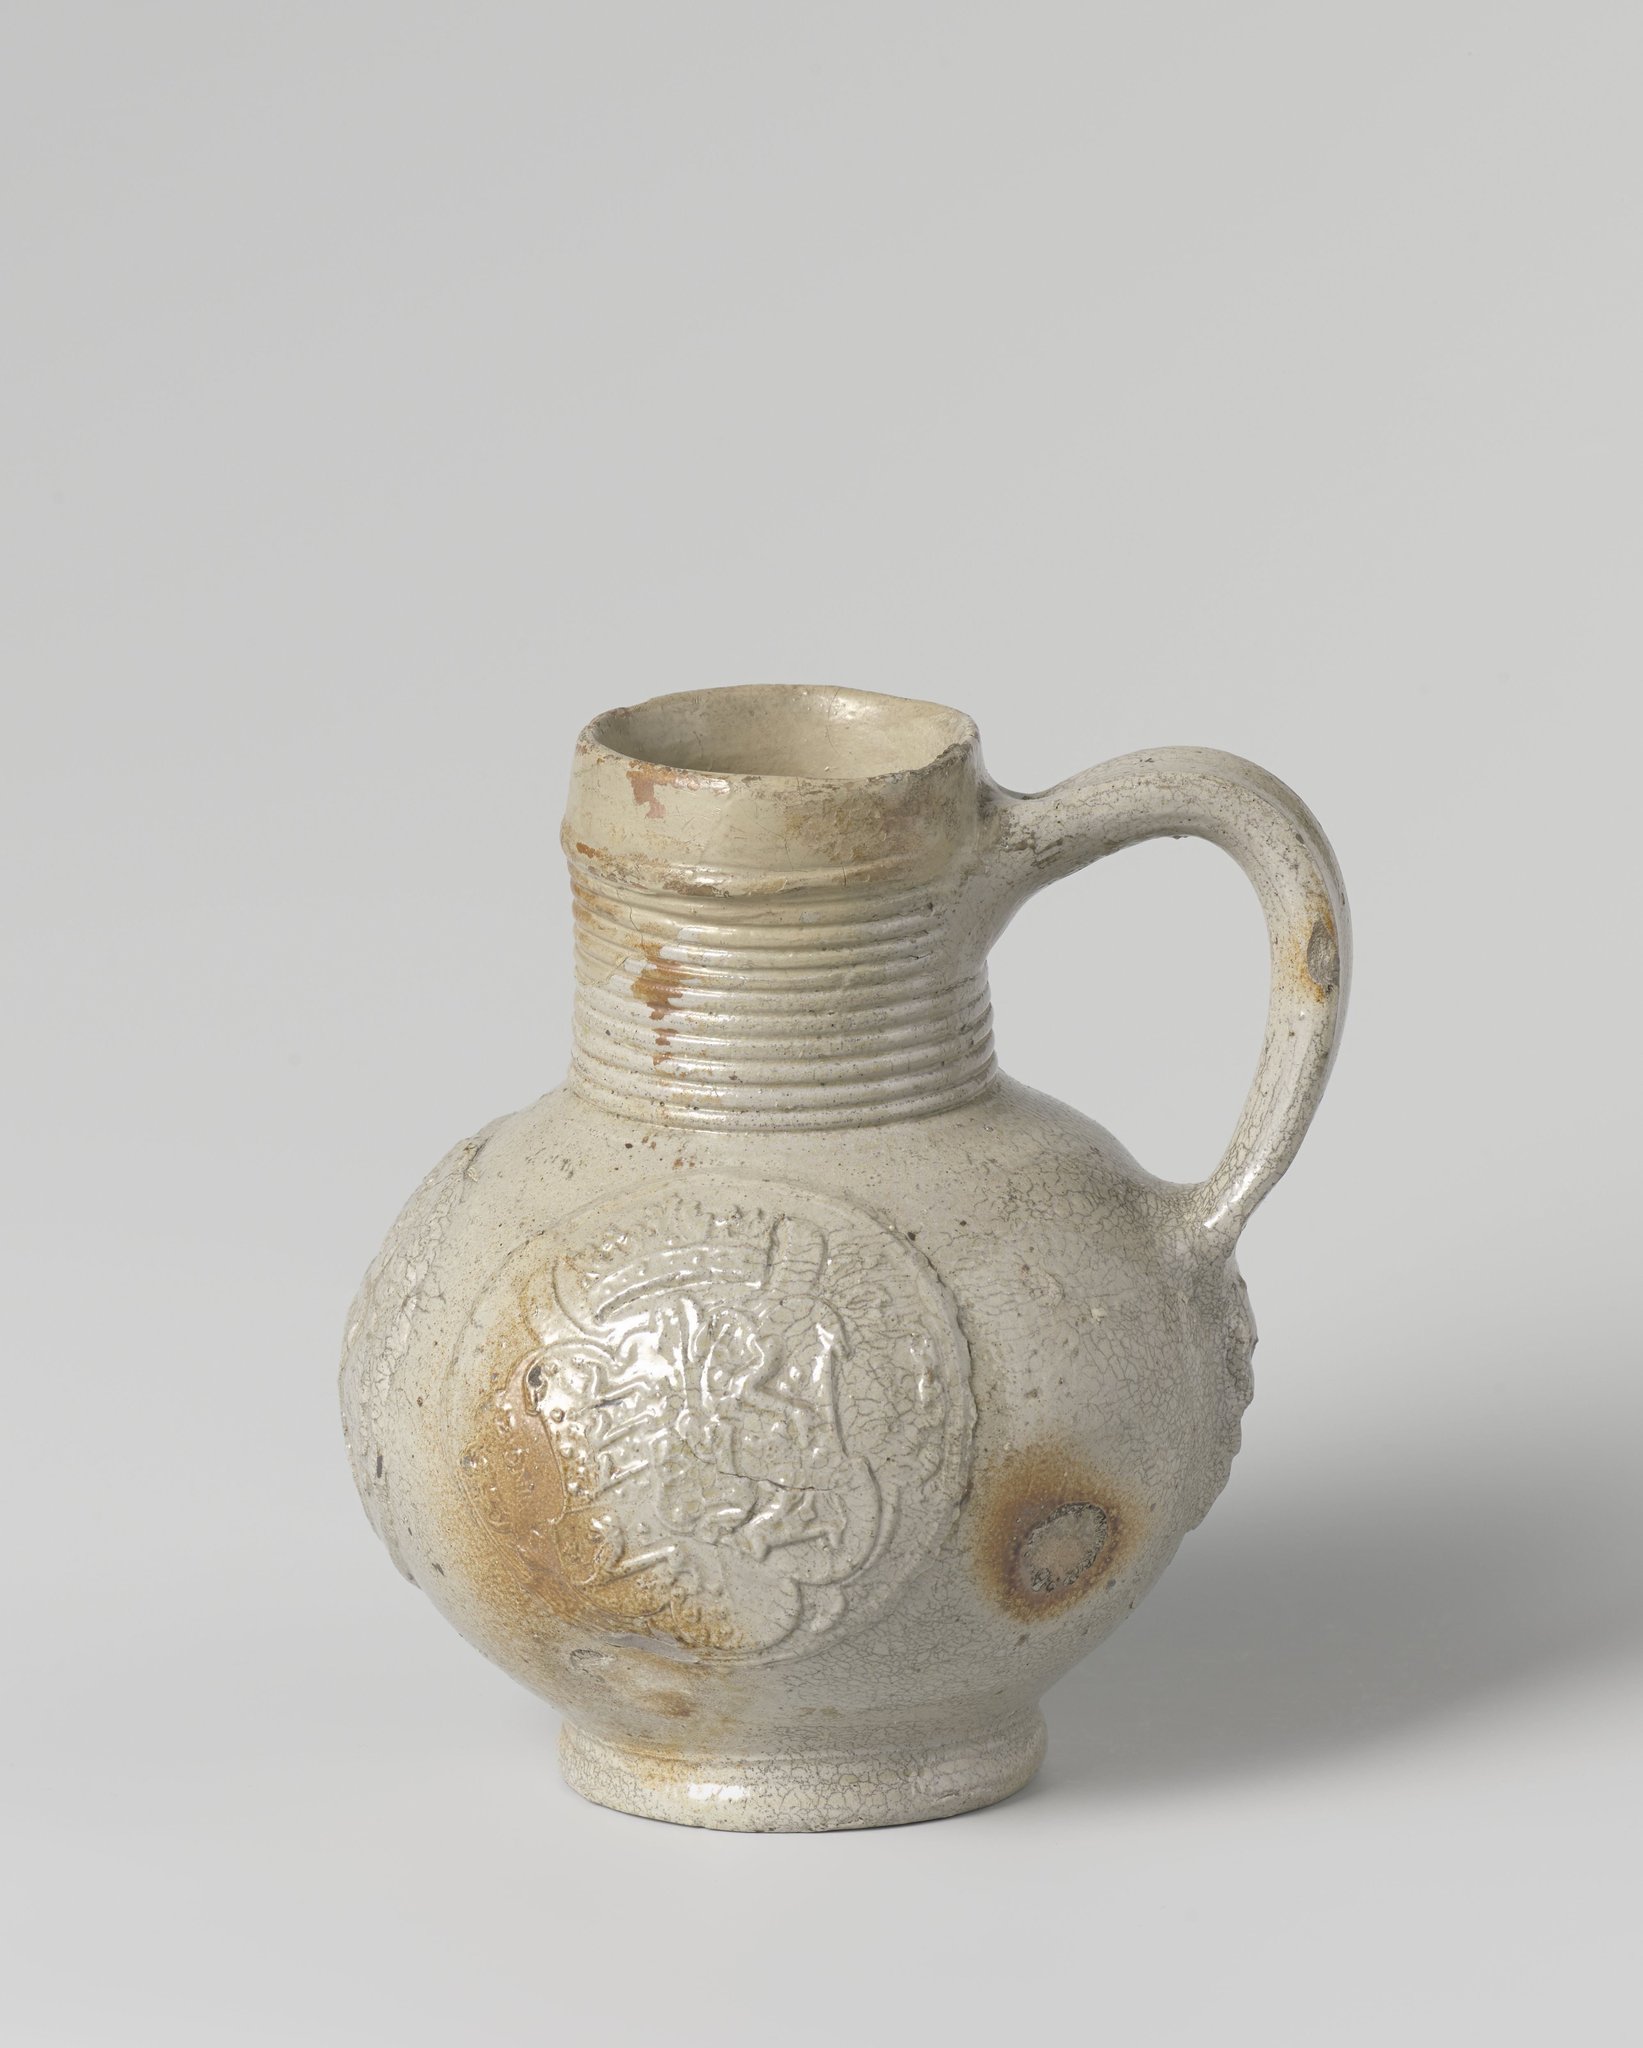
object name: jug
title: Jug with ribbed neck and coat of arms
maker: Anonymous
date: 1550-1599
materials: glaze, stoneware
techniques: firing, forming, relief, turning, vitrification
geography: raeren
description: Kruik van steengoed op standring met een bolvormig lichaam en wijde, geribde nek. Het C-vormige oor is bevestigd aan de nek en de schouder. Op de buik in reliëf driemaal een gedrukt en opgelegde wapen met een onleesbaar opschrift. Raeren.